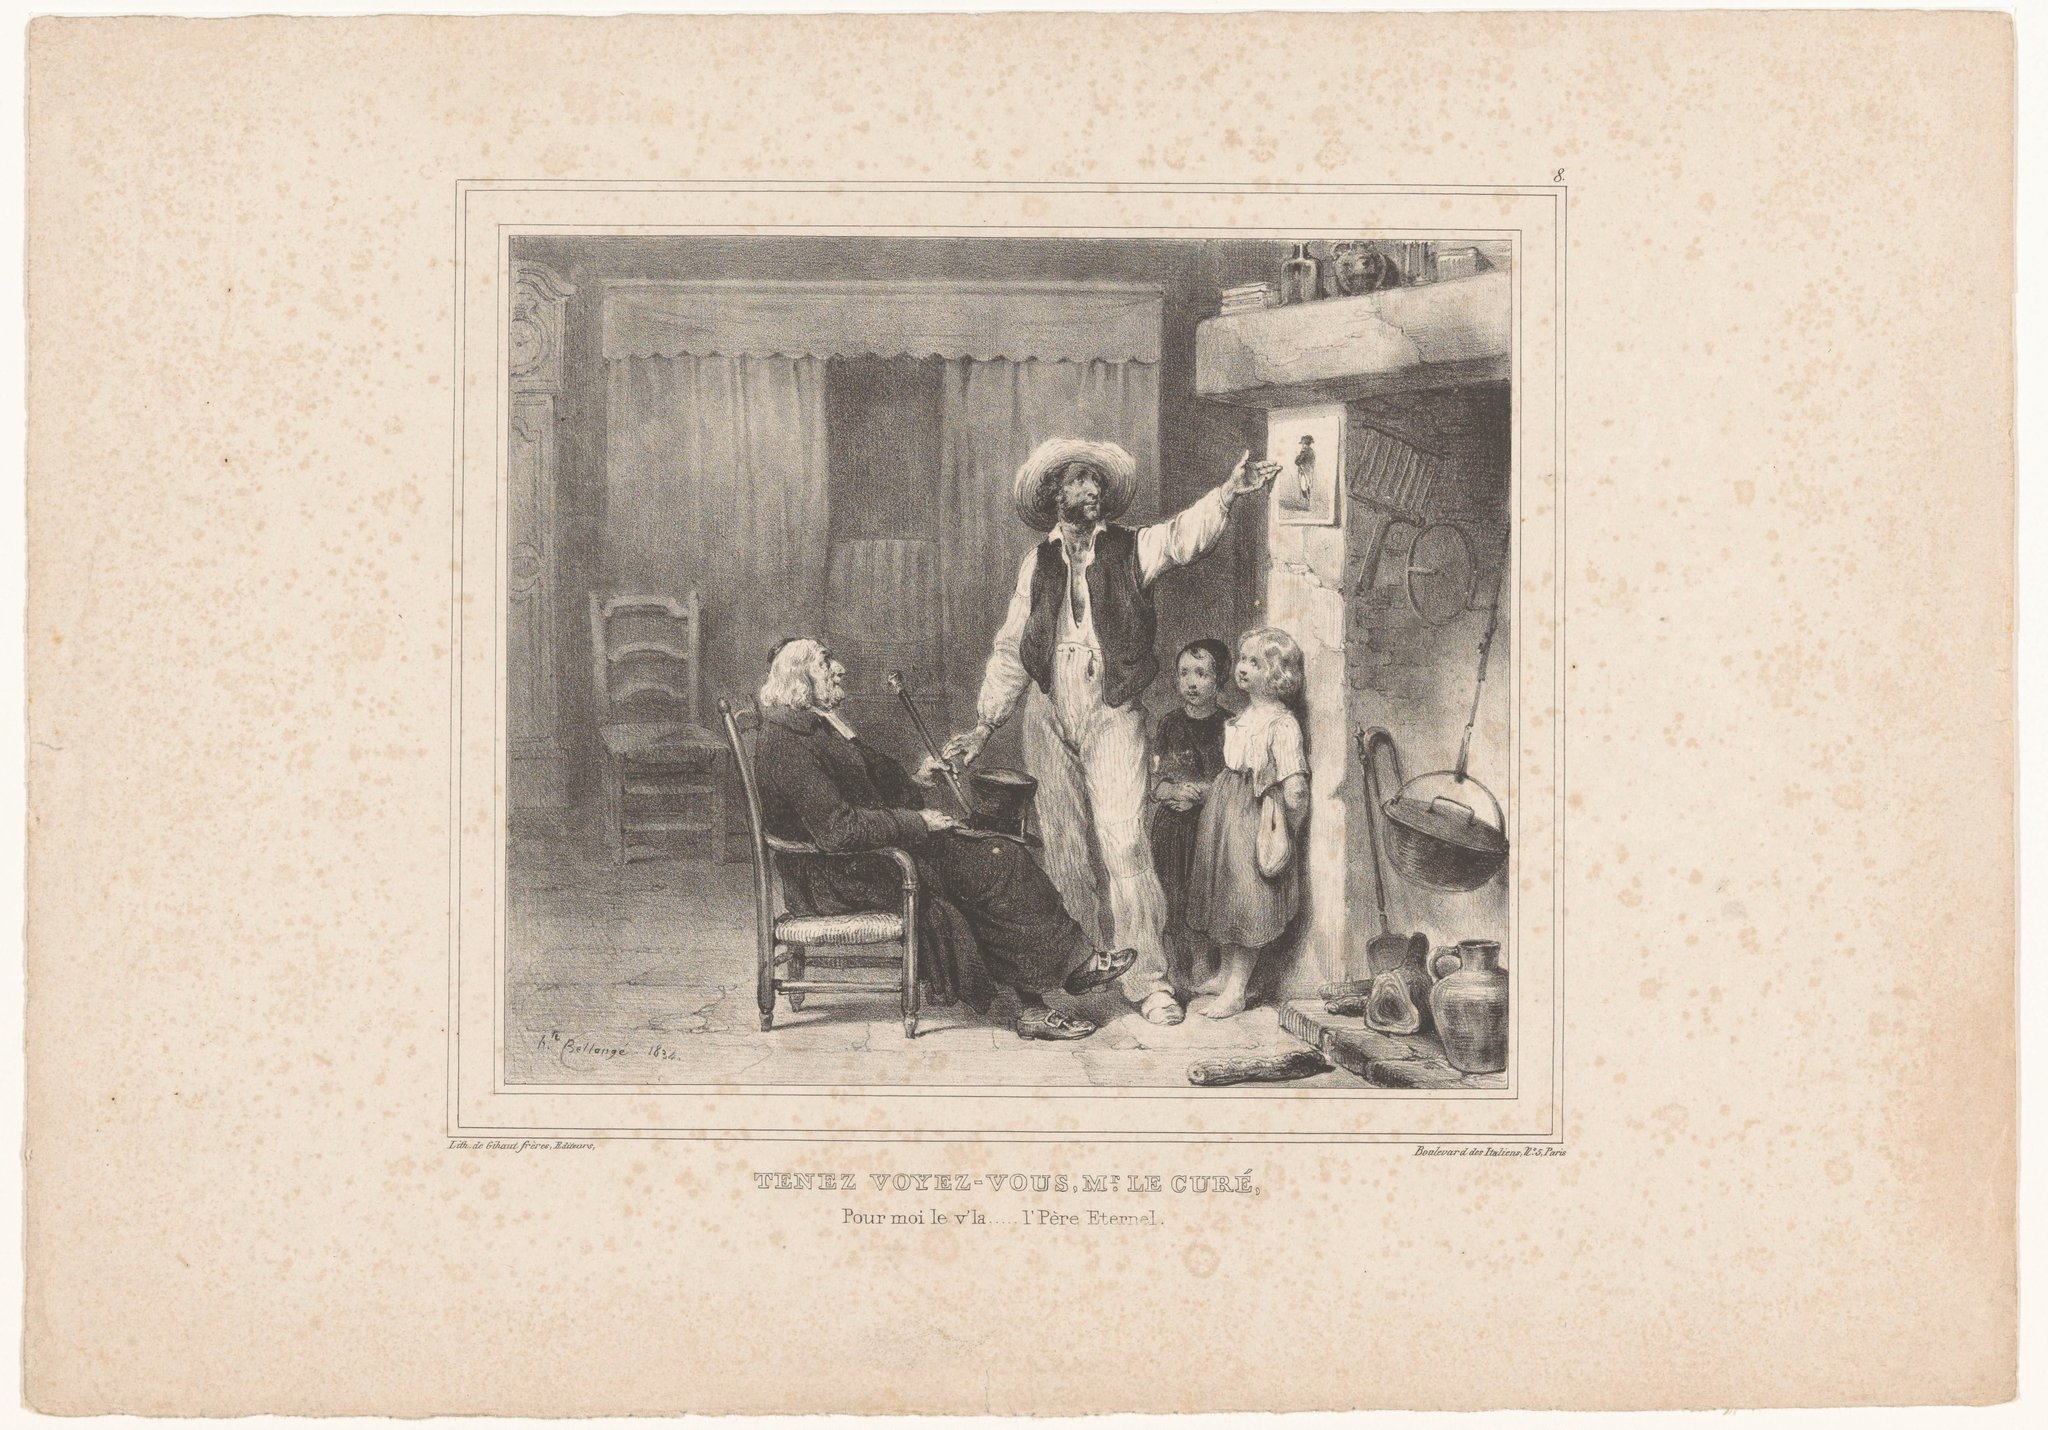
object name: print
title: Man toont priester een prent met Napoleon Bonaparte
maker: hippolyte bellangé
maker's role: draughtsman, print maker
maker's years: 1800-1866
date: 1834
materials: paper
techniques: lithograph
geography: paris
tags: priest (roman catholic), interior of the house, father and child(ren), man and child(ren) (family group)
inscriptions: collector's mark: Lugt 2228a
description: In een interieur wijst een arme vader van twee kinderen op een prent met Napoleon Bonaparte, die naast de haard hangt. Hij zegt tegen de priester in de stoel dat dit voor hem de 'Eeuwige Vader' is.